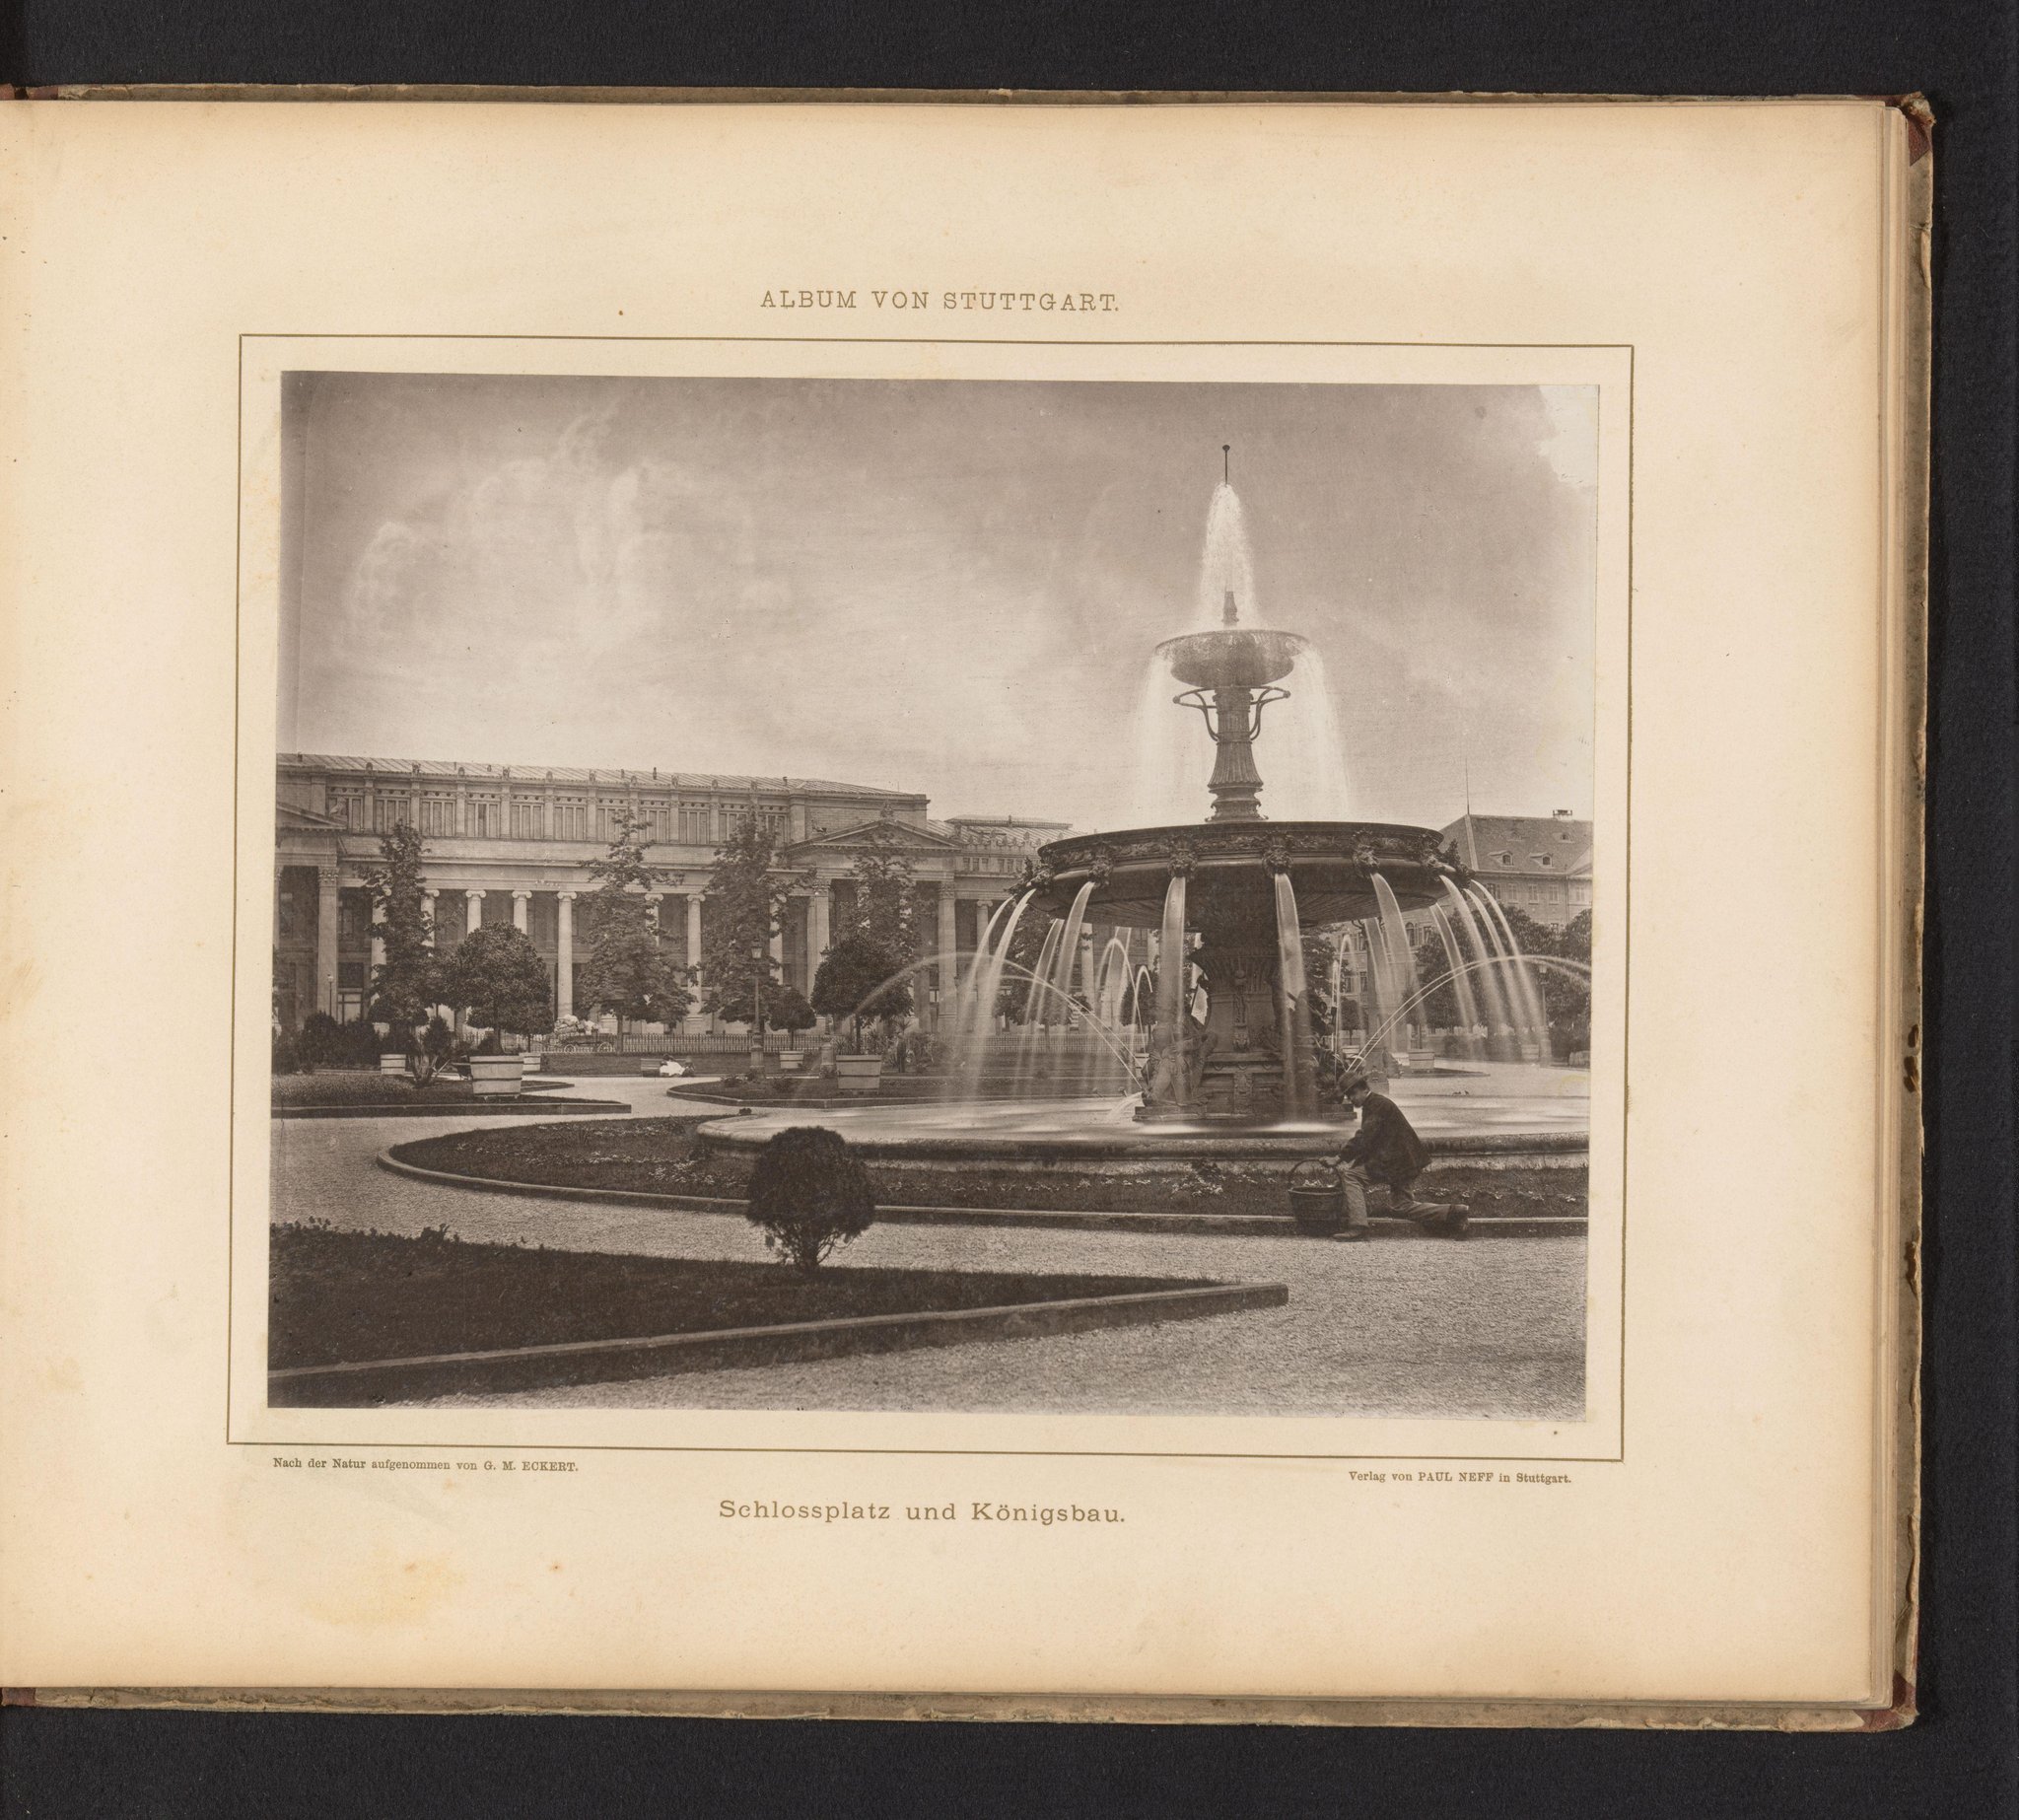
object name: photomechanical print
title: Gezicht op de Schlossplatz en Königsbau in Stuttgart, Duitsland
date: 1870-1875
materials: paper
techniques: photograph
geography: stuttgart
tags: square, place, circus, etc., civic architecture; edifices; dwellings